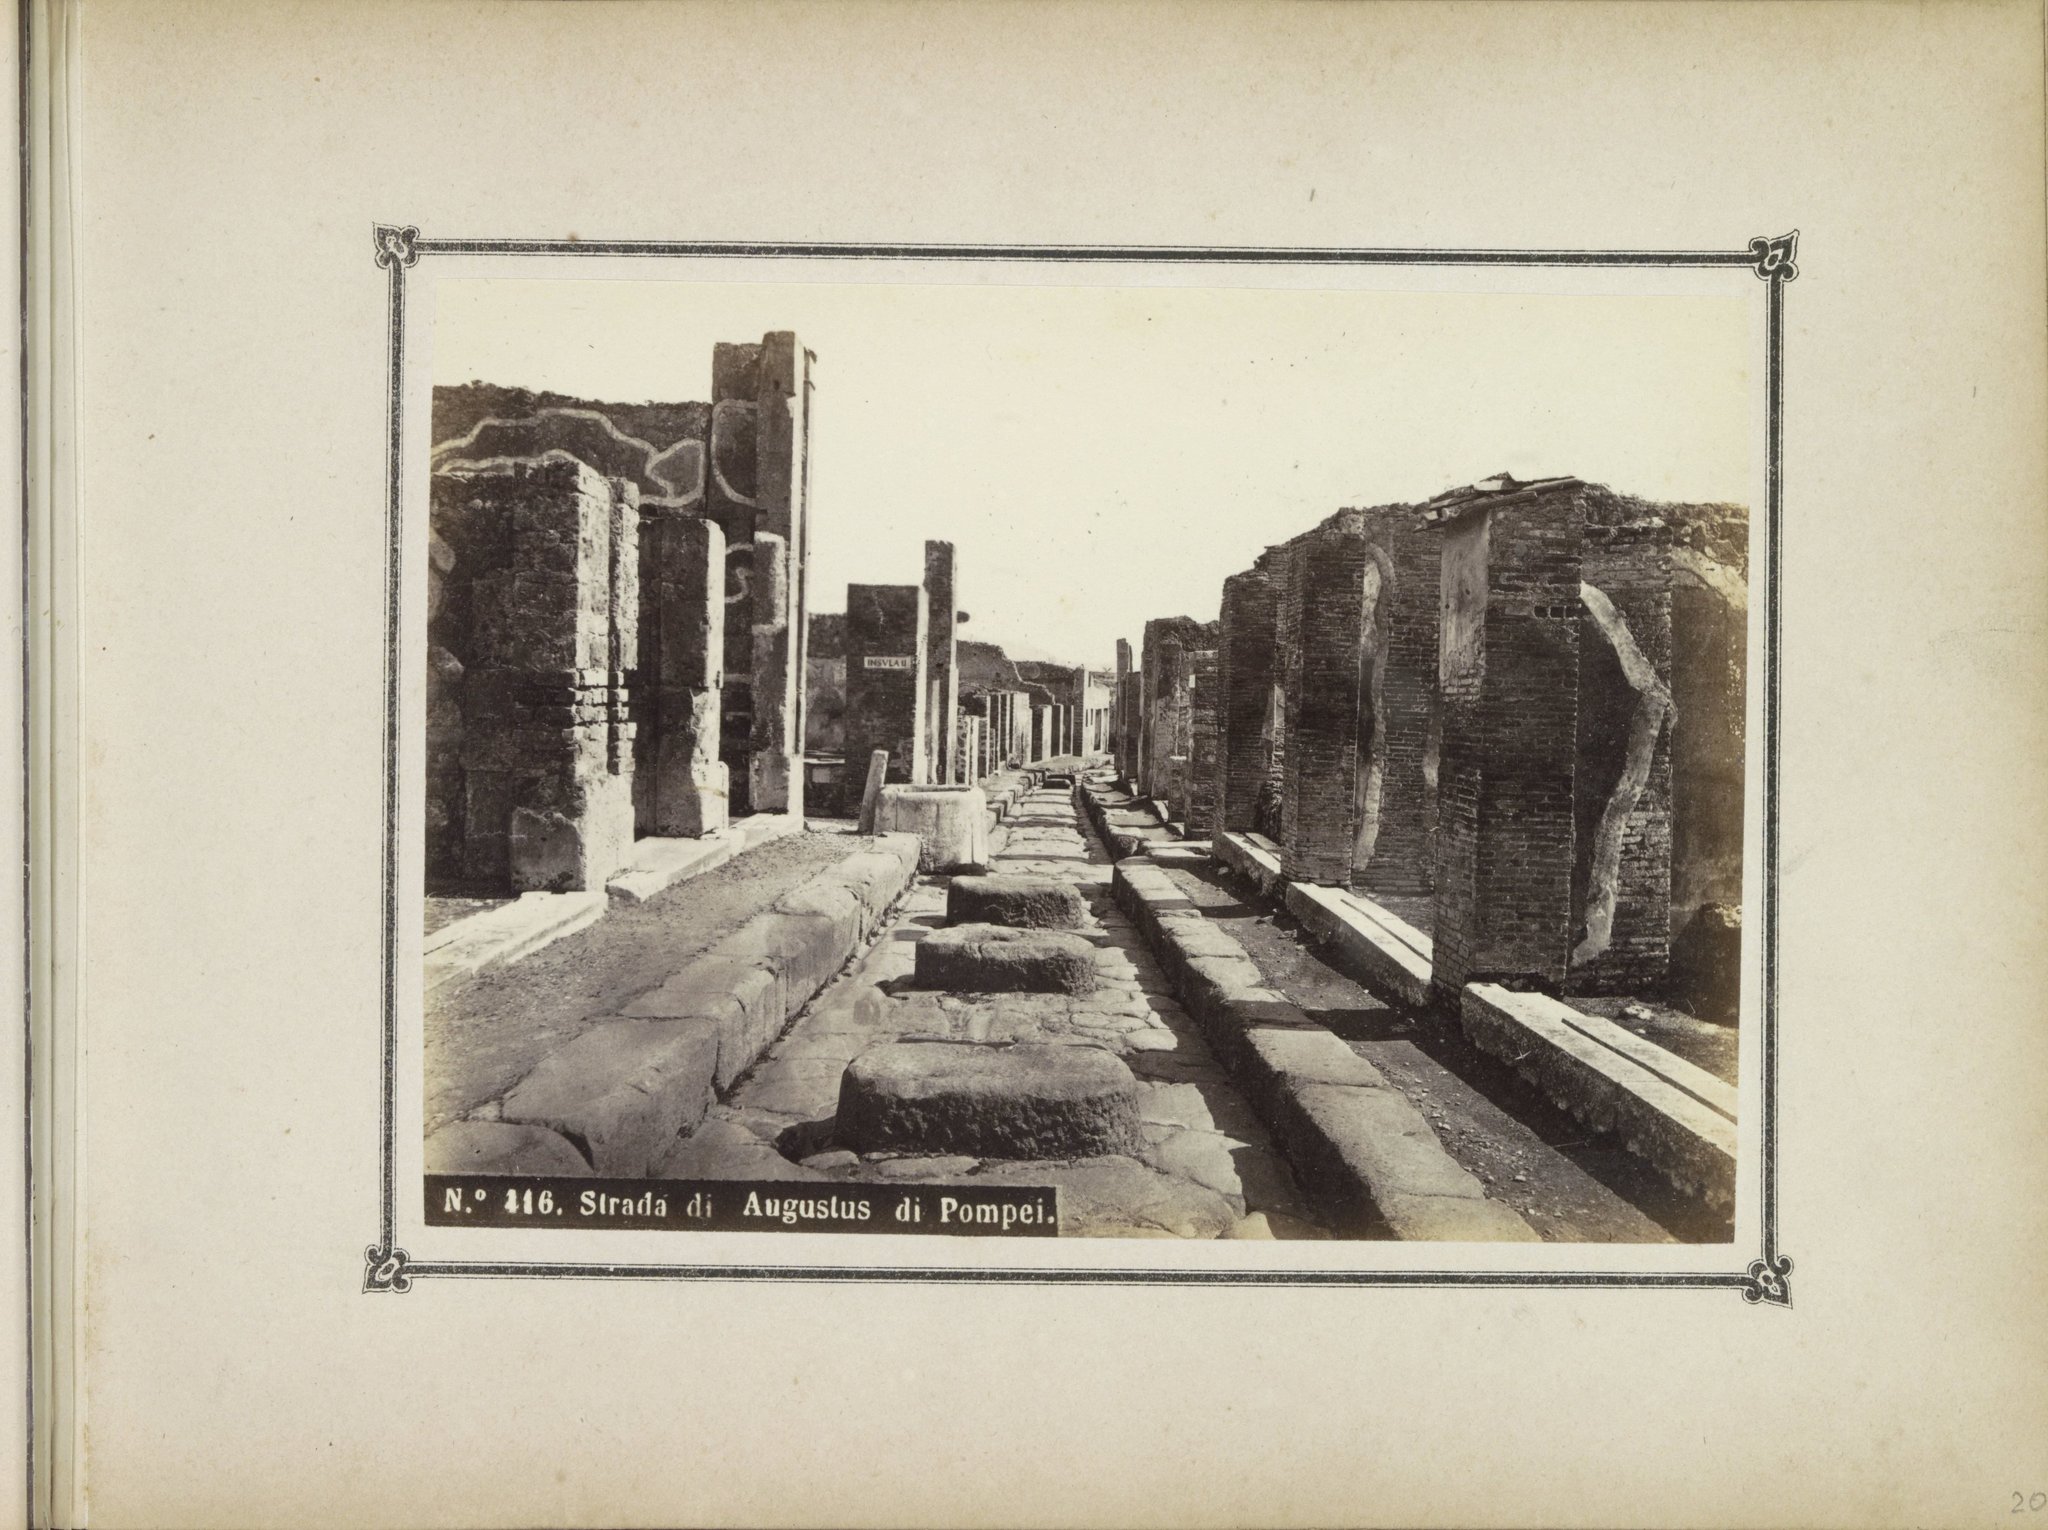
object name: photograph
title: Strada di Augustus di Pompei.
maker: roberto rive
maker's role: fotograaf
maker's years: 1825-1868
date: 1860-1900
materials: paper, photographic support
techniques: albumen print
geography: pompeii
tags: excavation ~ archaeology, street, pompeii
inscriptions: number: ‘416’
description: Onderdeel van Fotoalbum met opnames van opgravingen in Pompeï door Roberto Rive.